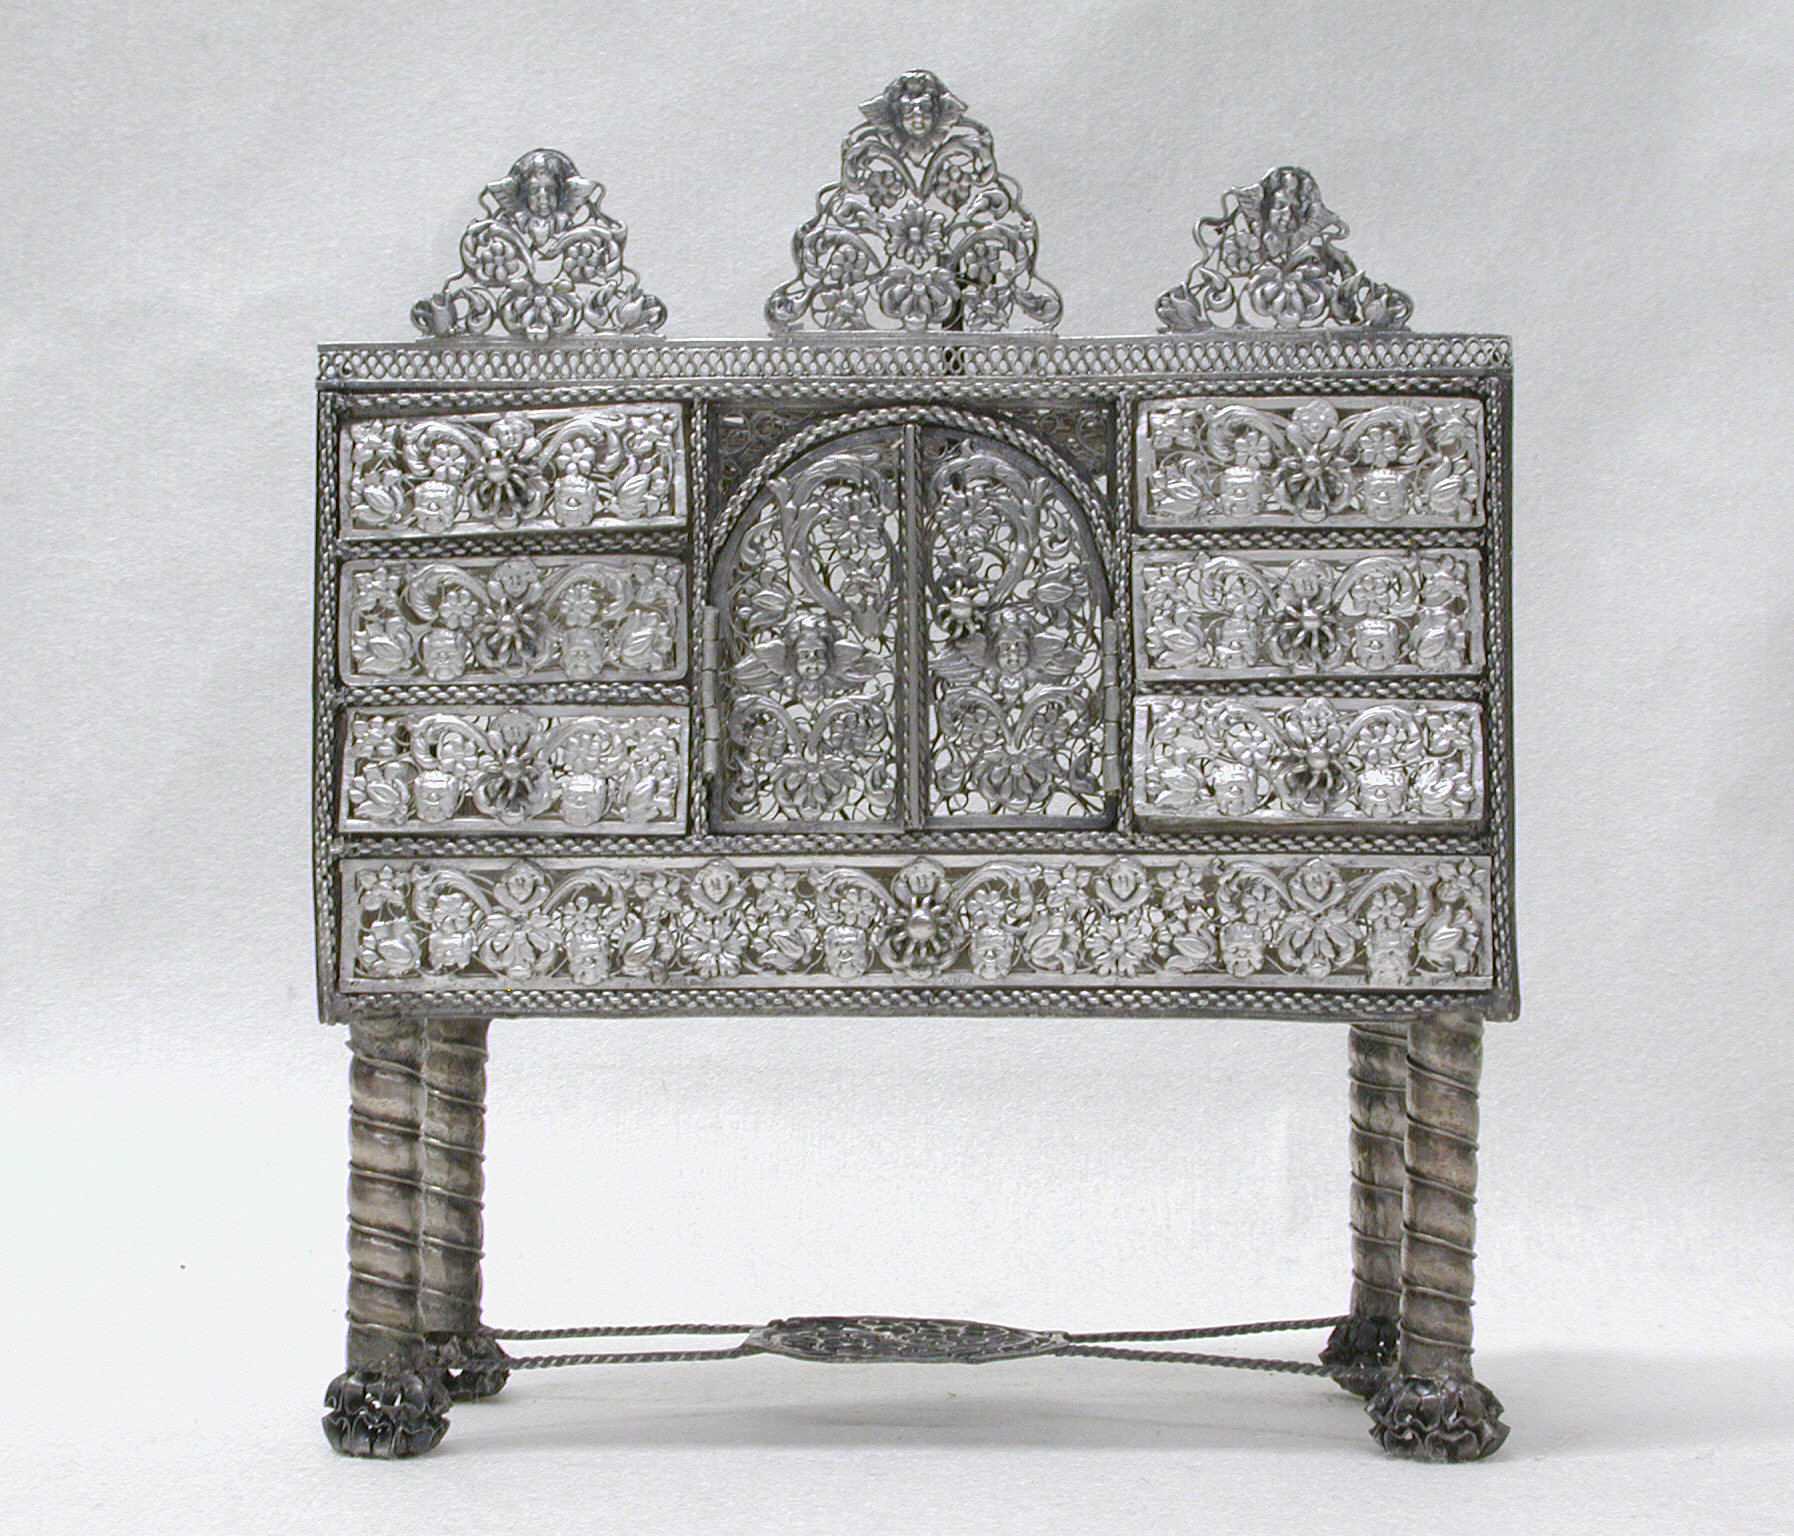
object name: cabinet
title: Miniature cabinet (part of a set)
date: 1675-1700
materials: silver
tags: faces,flowers